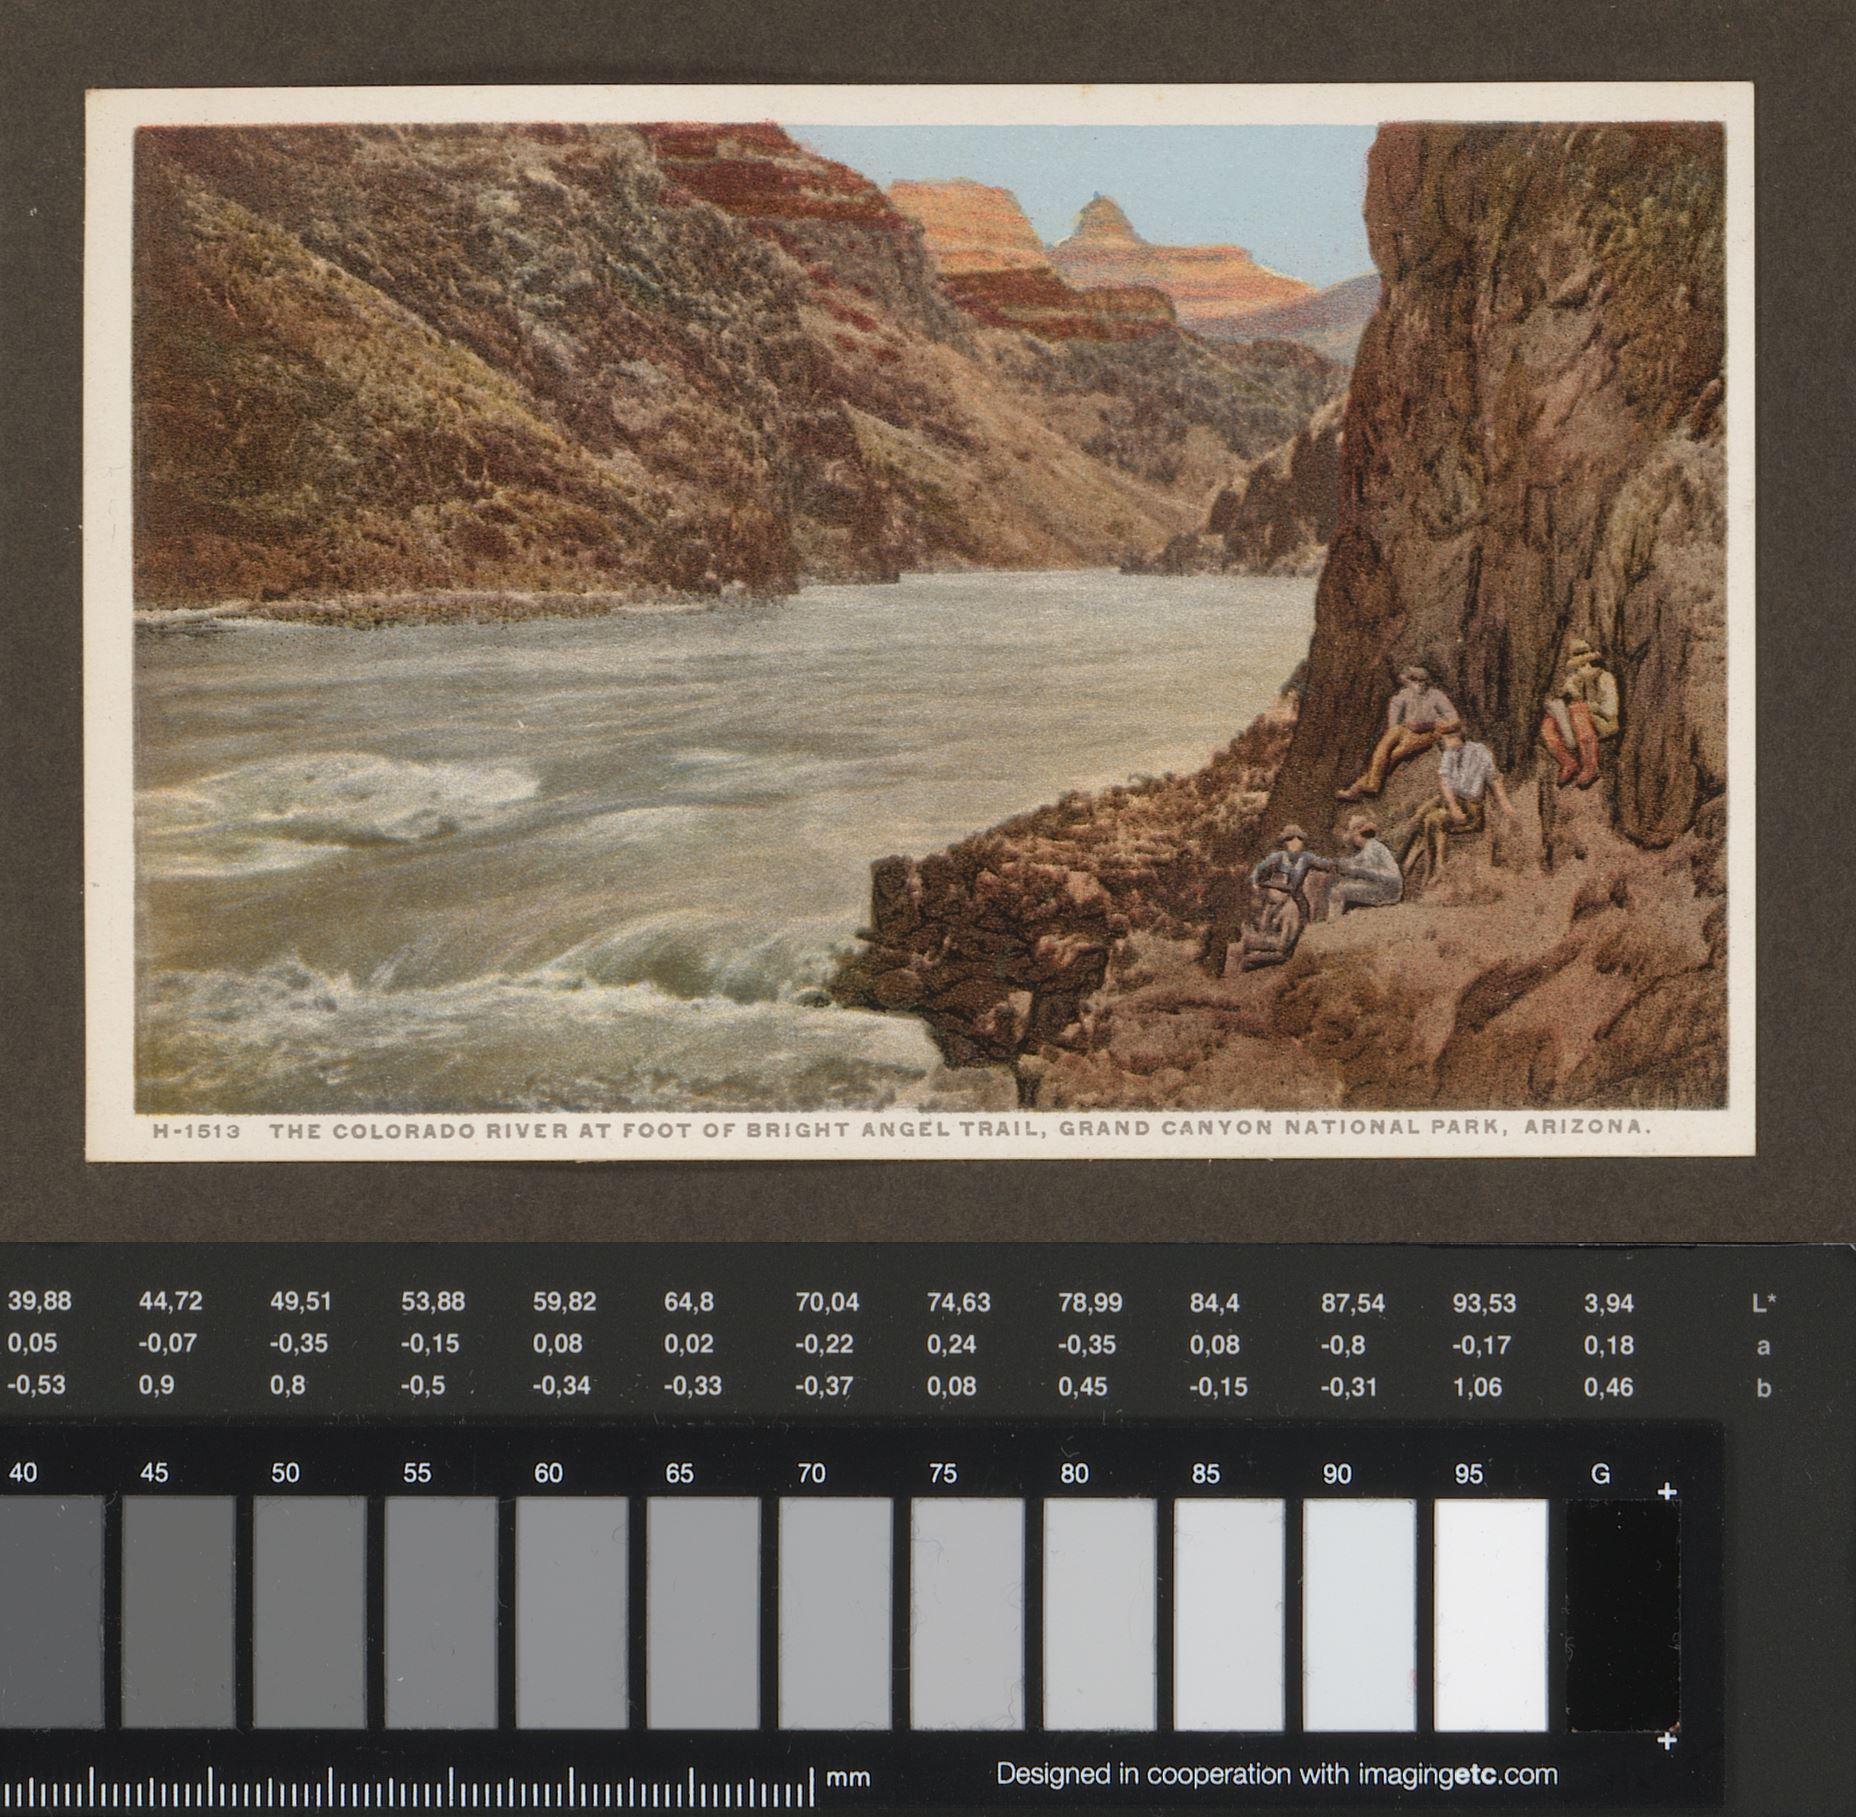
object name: ansichtkaart, prentbriefkaart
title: The Colorado River at foot of Bright Angel Trail, Grand Canyon National Park, Arizona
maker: Anonymous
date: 1928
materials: paper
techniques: four-color autotype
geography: grand canyon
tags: river, ravine, chasm, abyss, canyon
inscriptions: annotation: ‘Grand Canyon’, number: ‘H - 1513’